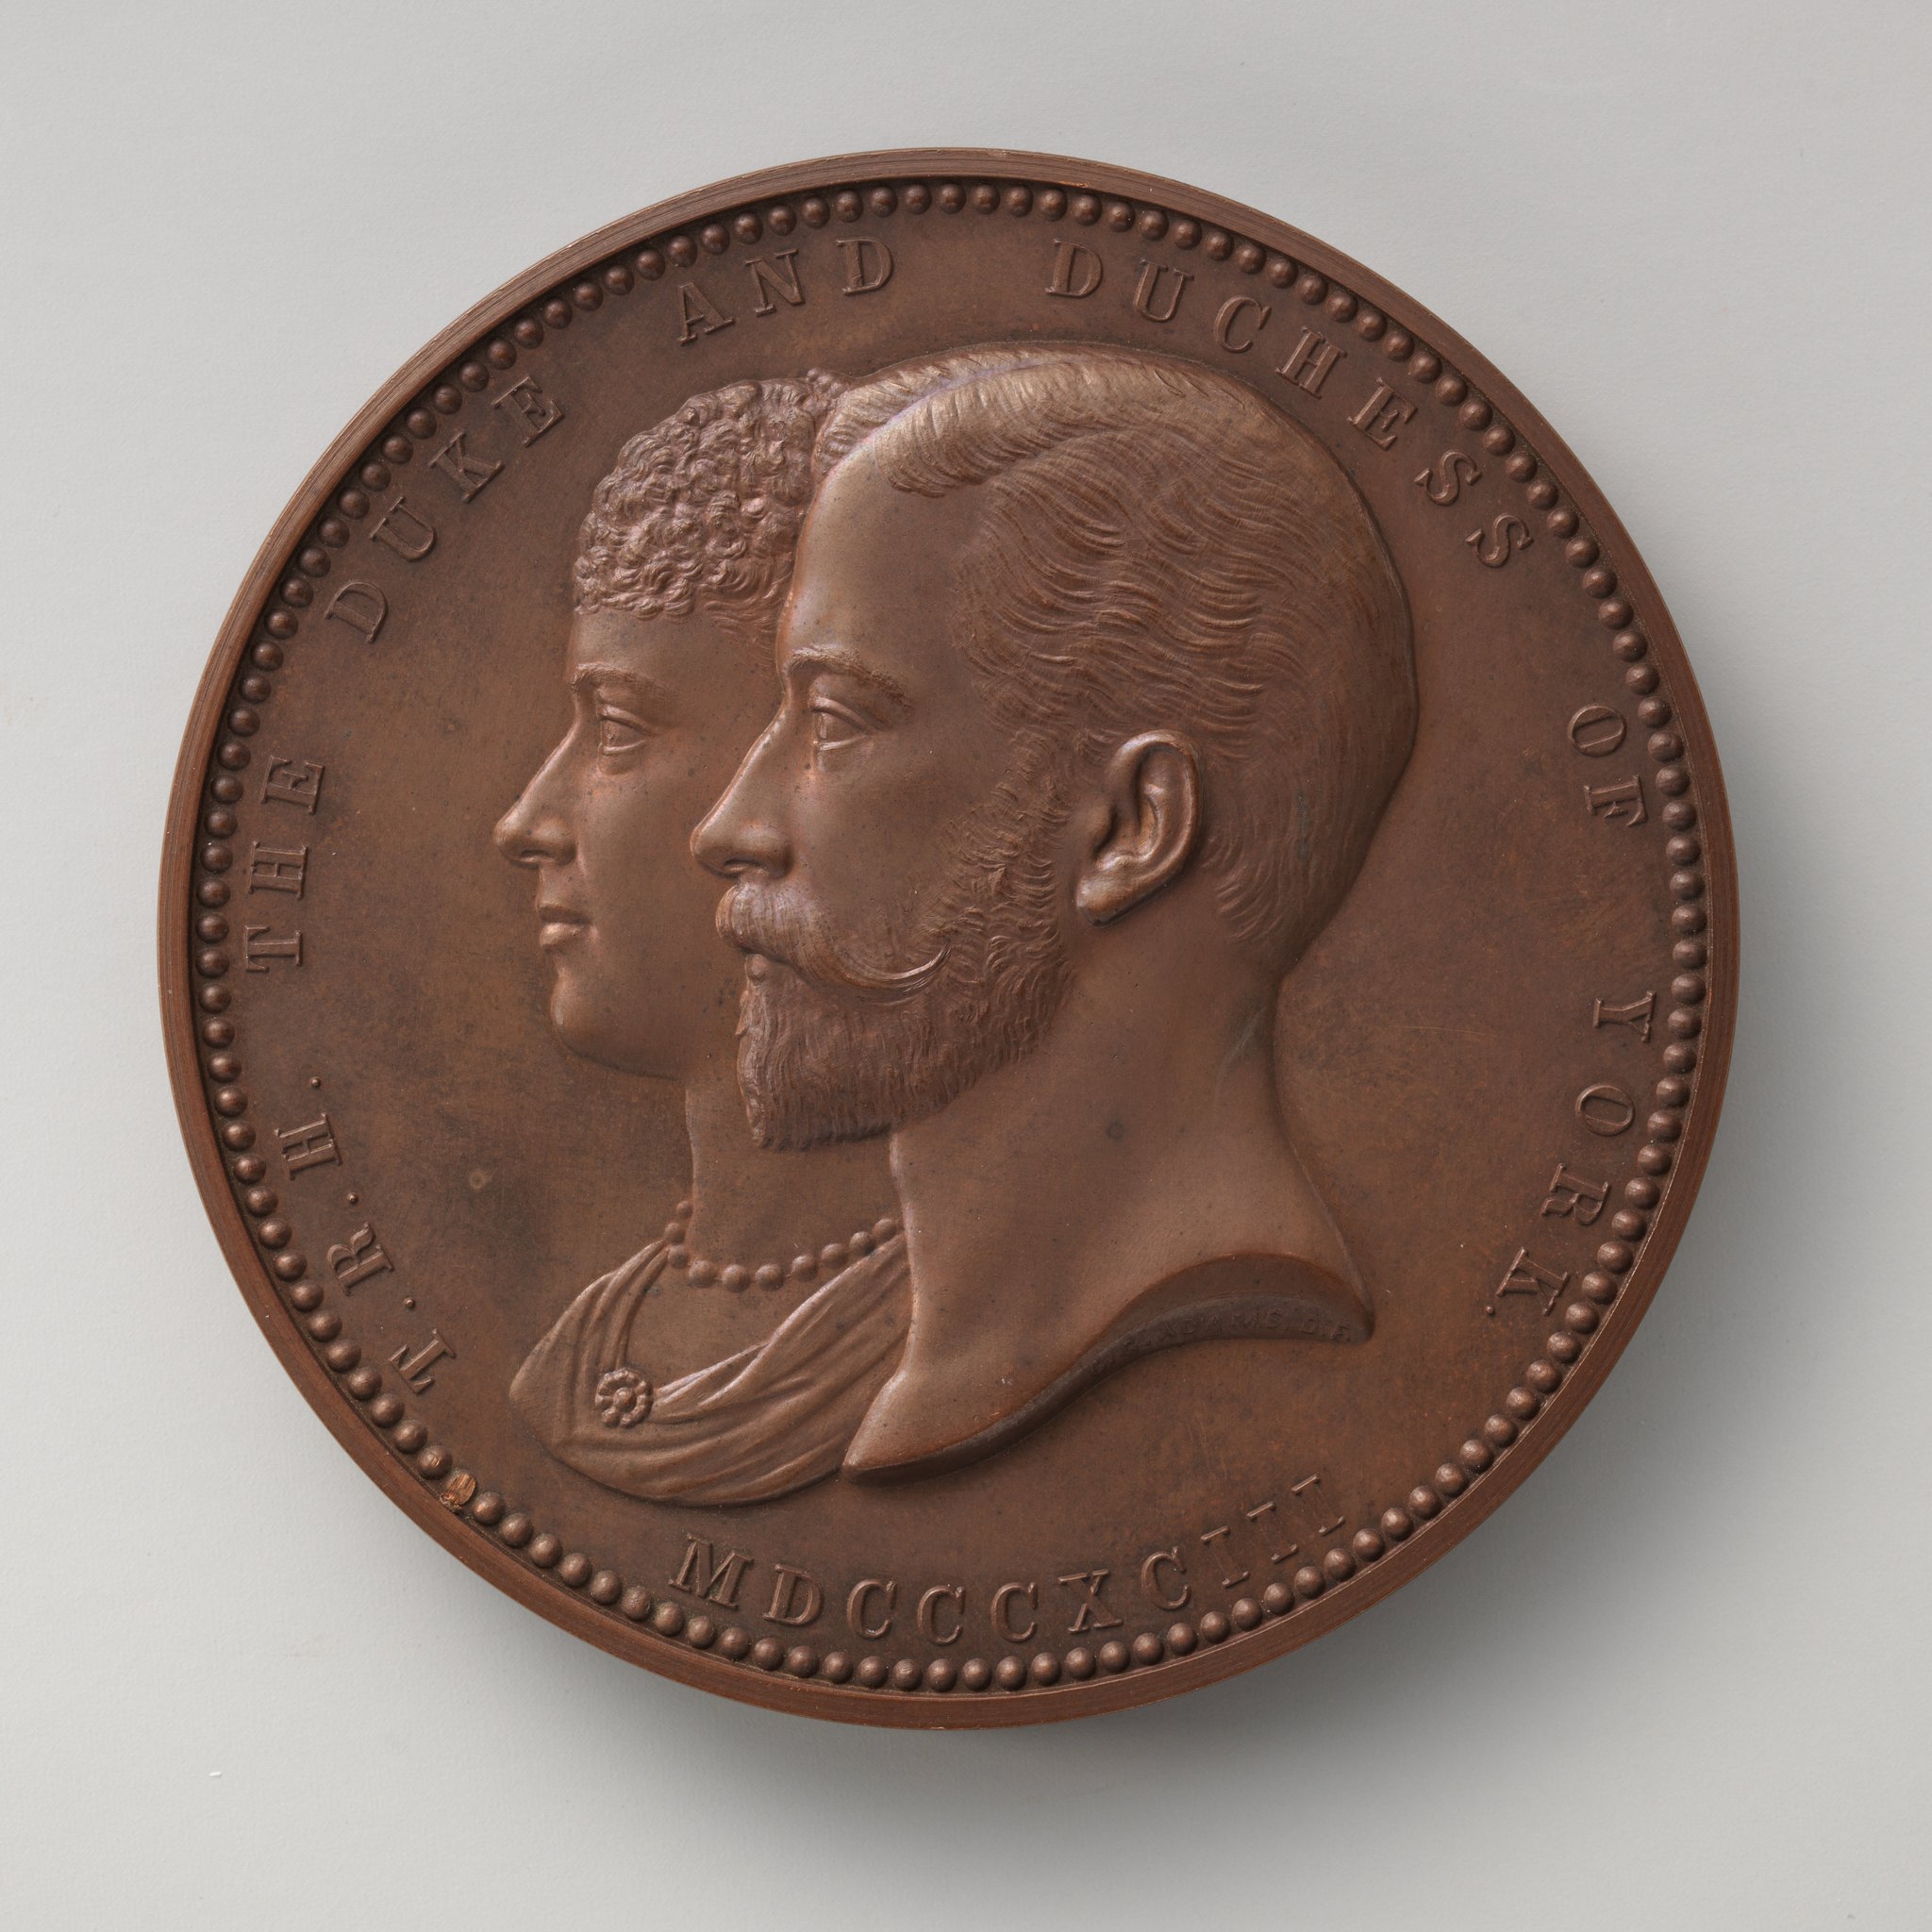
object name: medal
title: The Marriage and Visit to the City of the Duke and Duchess of York, July 6, 1893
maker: george gammon adams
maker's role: artist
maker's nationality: british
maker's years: 1821-1898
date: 1893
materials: bronze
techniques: struck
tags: men,profiles,women